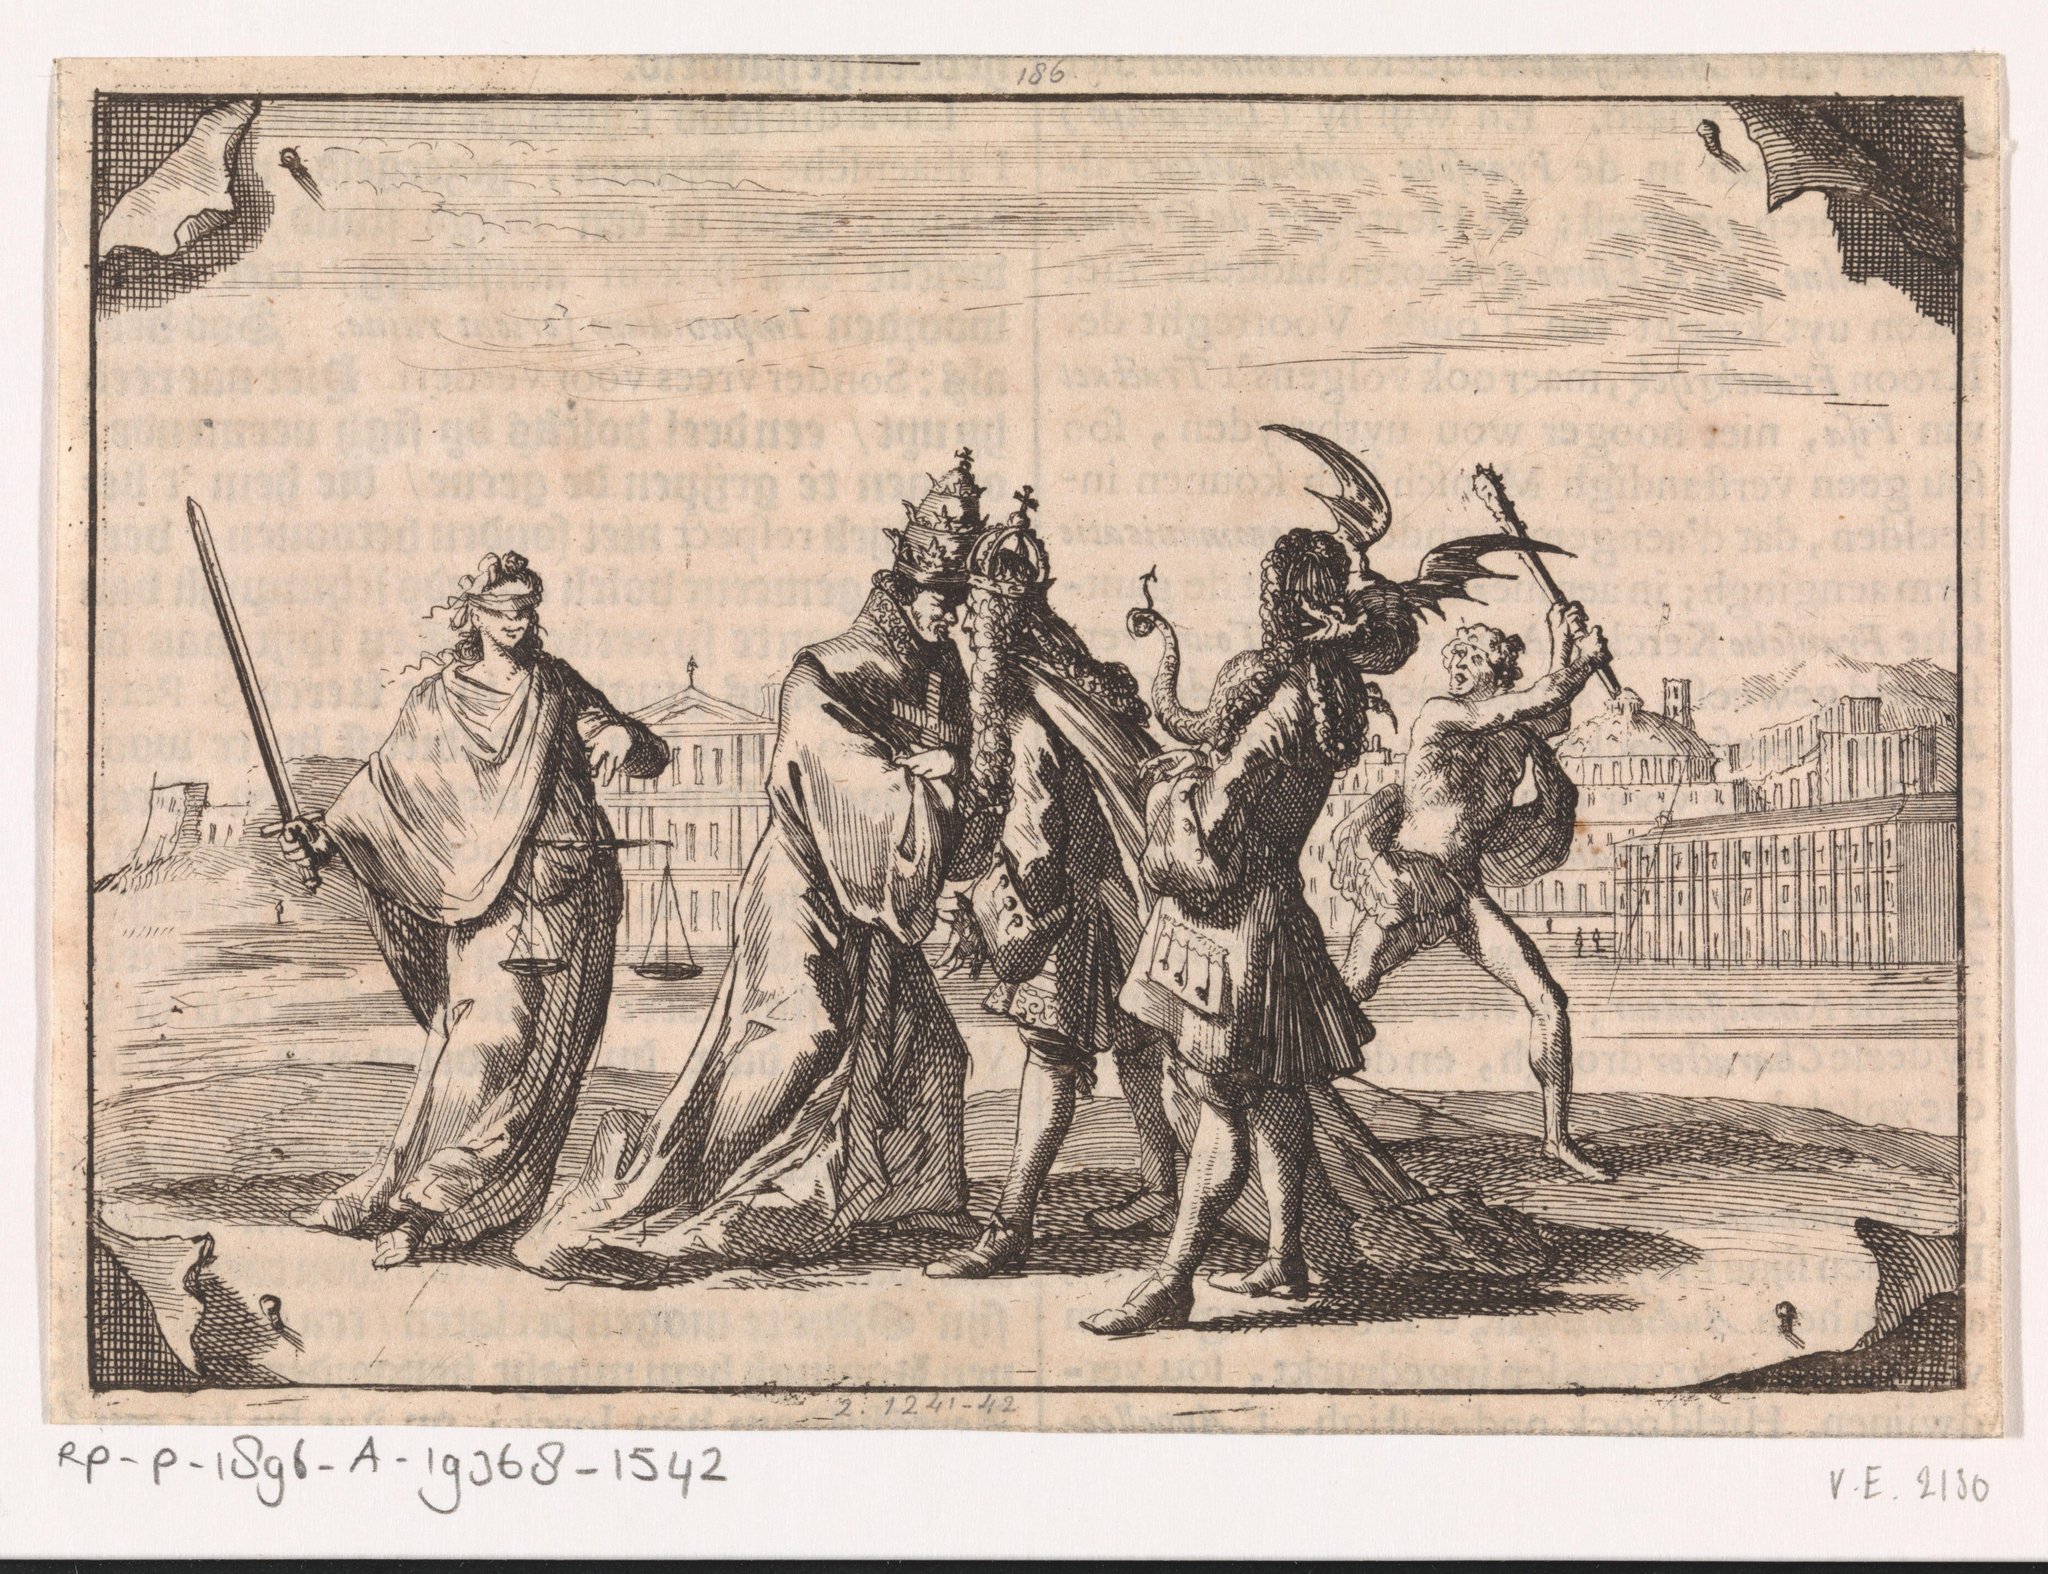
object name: print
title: Spotprent over de strijd tussen Lodewijk XIV en paus Innocentius XI, 1687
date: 1698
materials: paper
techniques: etching, letterpress printing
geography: amsterdam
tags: lodewijk xiv (koning van frankrijk), rome, clergyman, innocentius xi, (story of) hercules (heracles), justice, 'justitia'; 'giustitia divina' (ripa) ~ one of the four cardinal virtues, battle, fighting in general, devil(s) and demons: satan, political caricatures and satires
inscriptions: collector's mark: Lugt 2228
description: Illustratie uit: Gottfried, Johann Ludwig. Historische kronyck; vervattende een (...) beschrijvingh der aldergedenckwaerdigste geschiedenissen des weerelds, van den aenvangh der scheppingh tot (...) 1576 (2 delen). Leiden: Pieter van der Aa, 1698, dl. II, p. 1241.